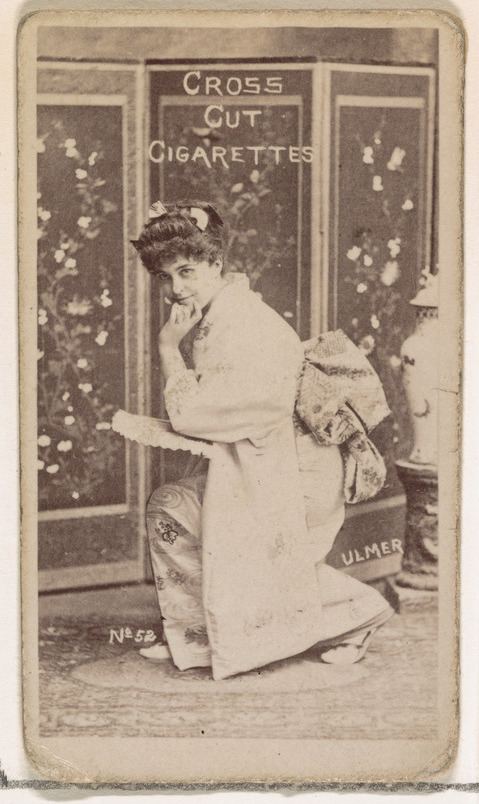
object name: print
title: Card Number 52, Geraldine Ulmer, from the Actors and Actresses series (N145-1) issued by Duke Sons & Co. to promote Cross Cut Cigarettes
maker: w. duke, sons & co.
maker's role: publisher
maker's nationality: american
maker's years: 1870-1920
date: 1880-1889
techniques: albumen silver print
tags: portraits,women,actresses